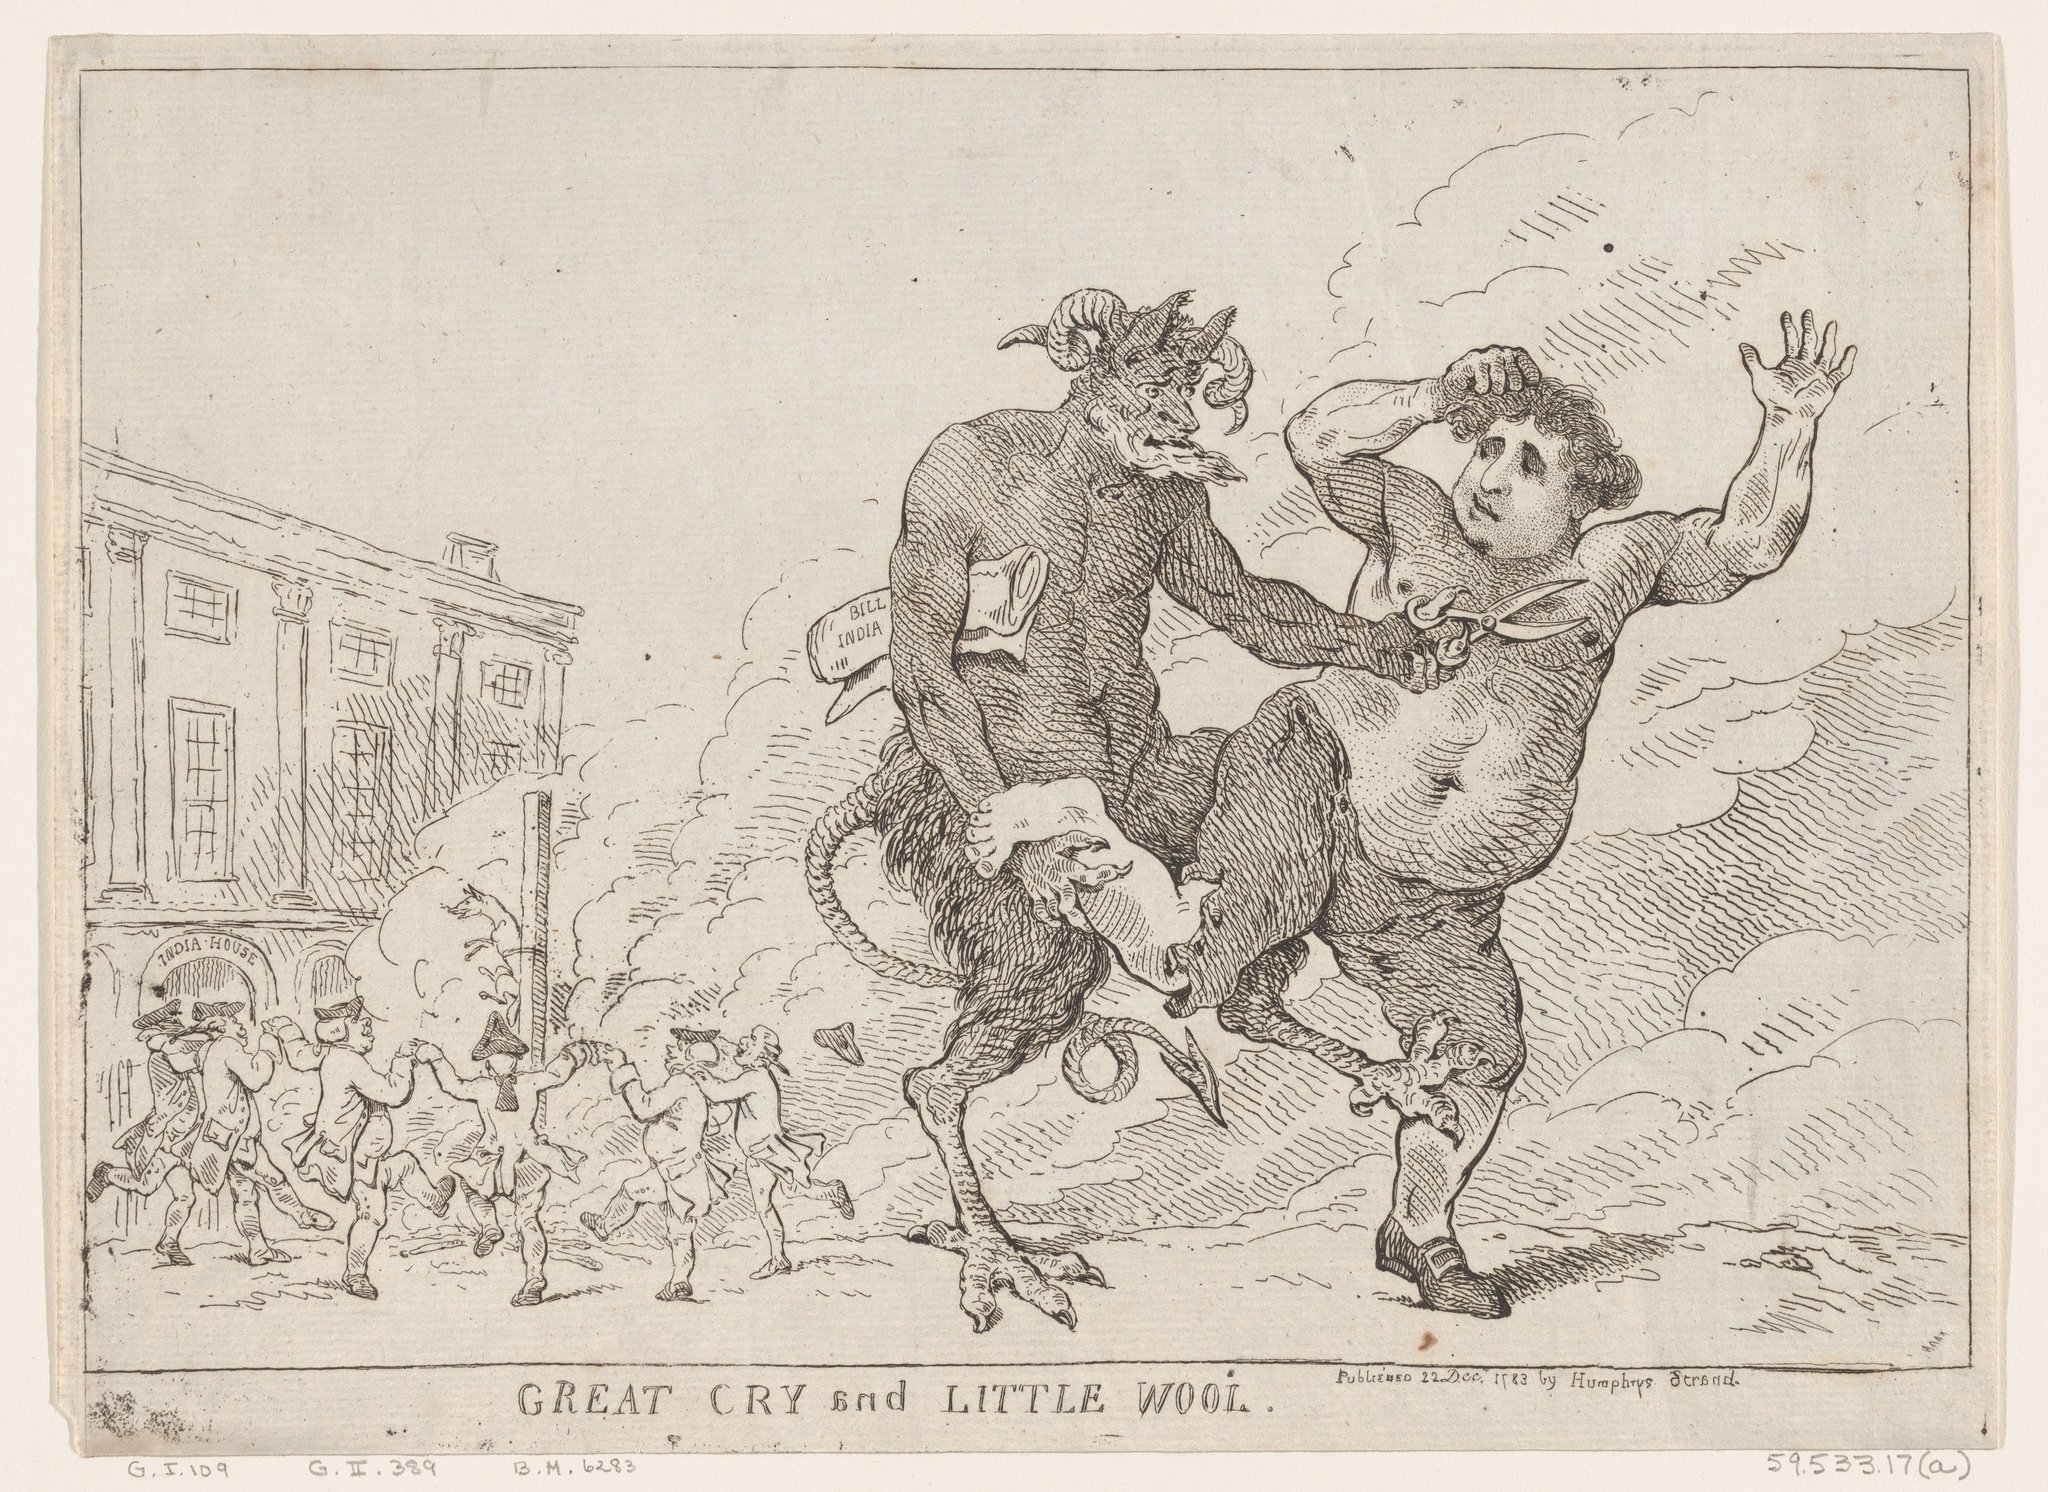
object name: print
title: Great Cry and Little Wool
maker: thomas rowlandson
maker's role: artist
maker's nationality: british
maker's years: 1757-1827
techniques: etching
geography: london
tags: satire,men,devil,politics